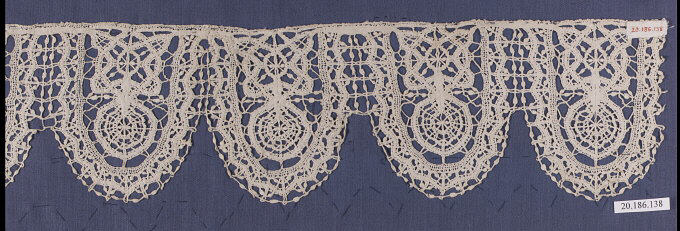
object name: edging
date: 1601-1700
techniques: lace